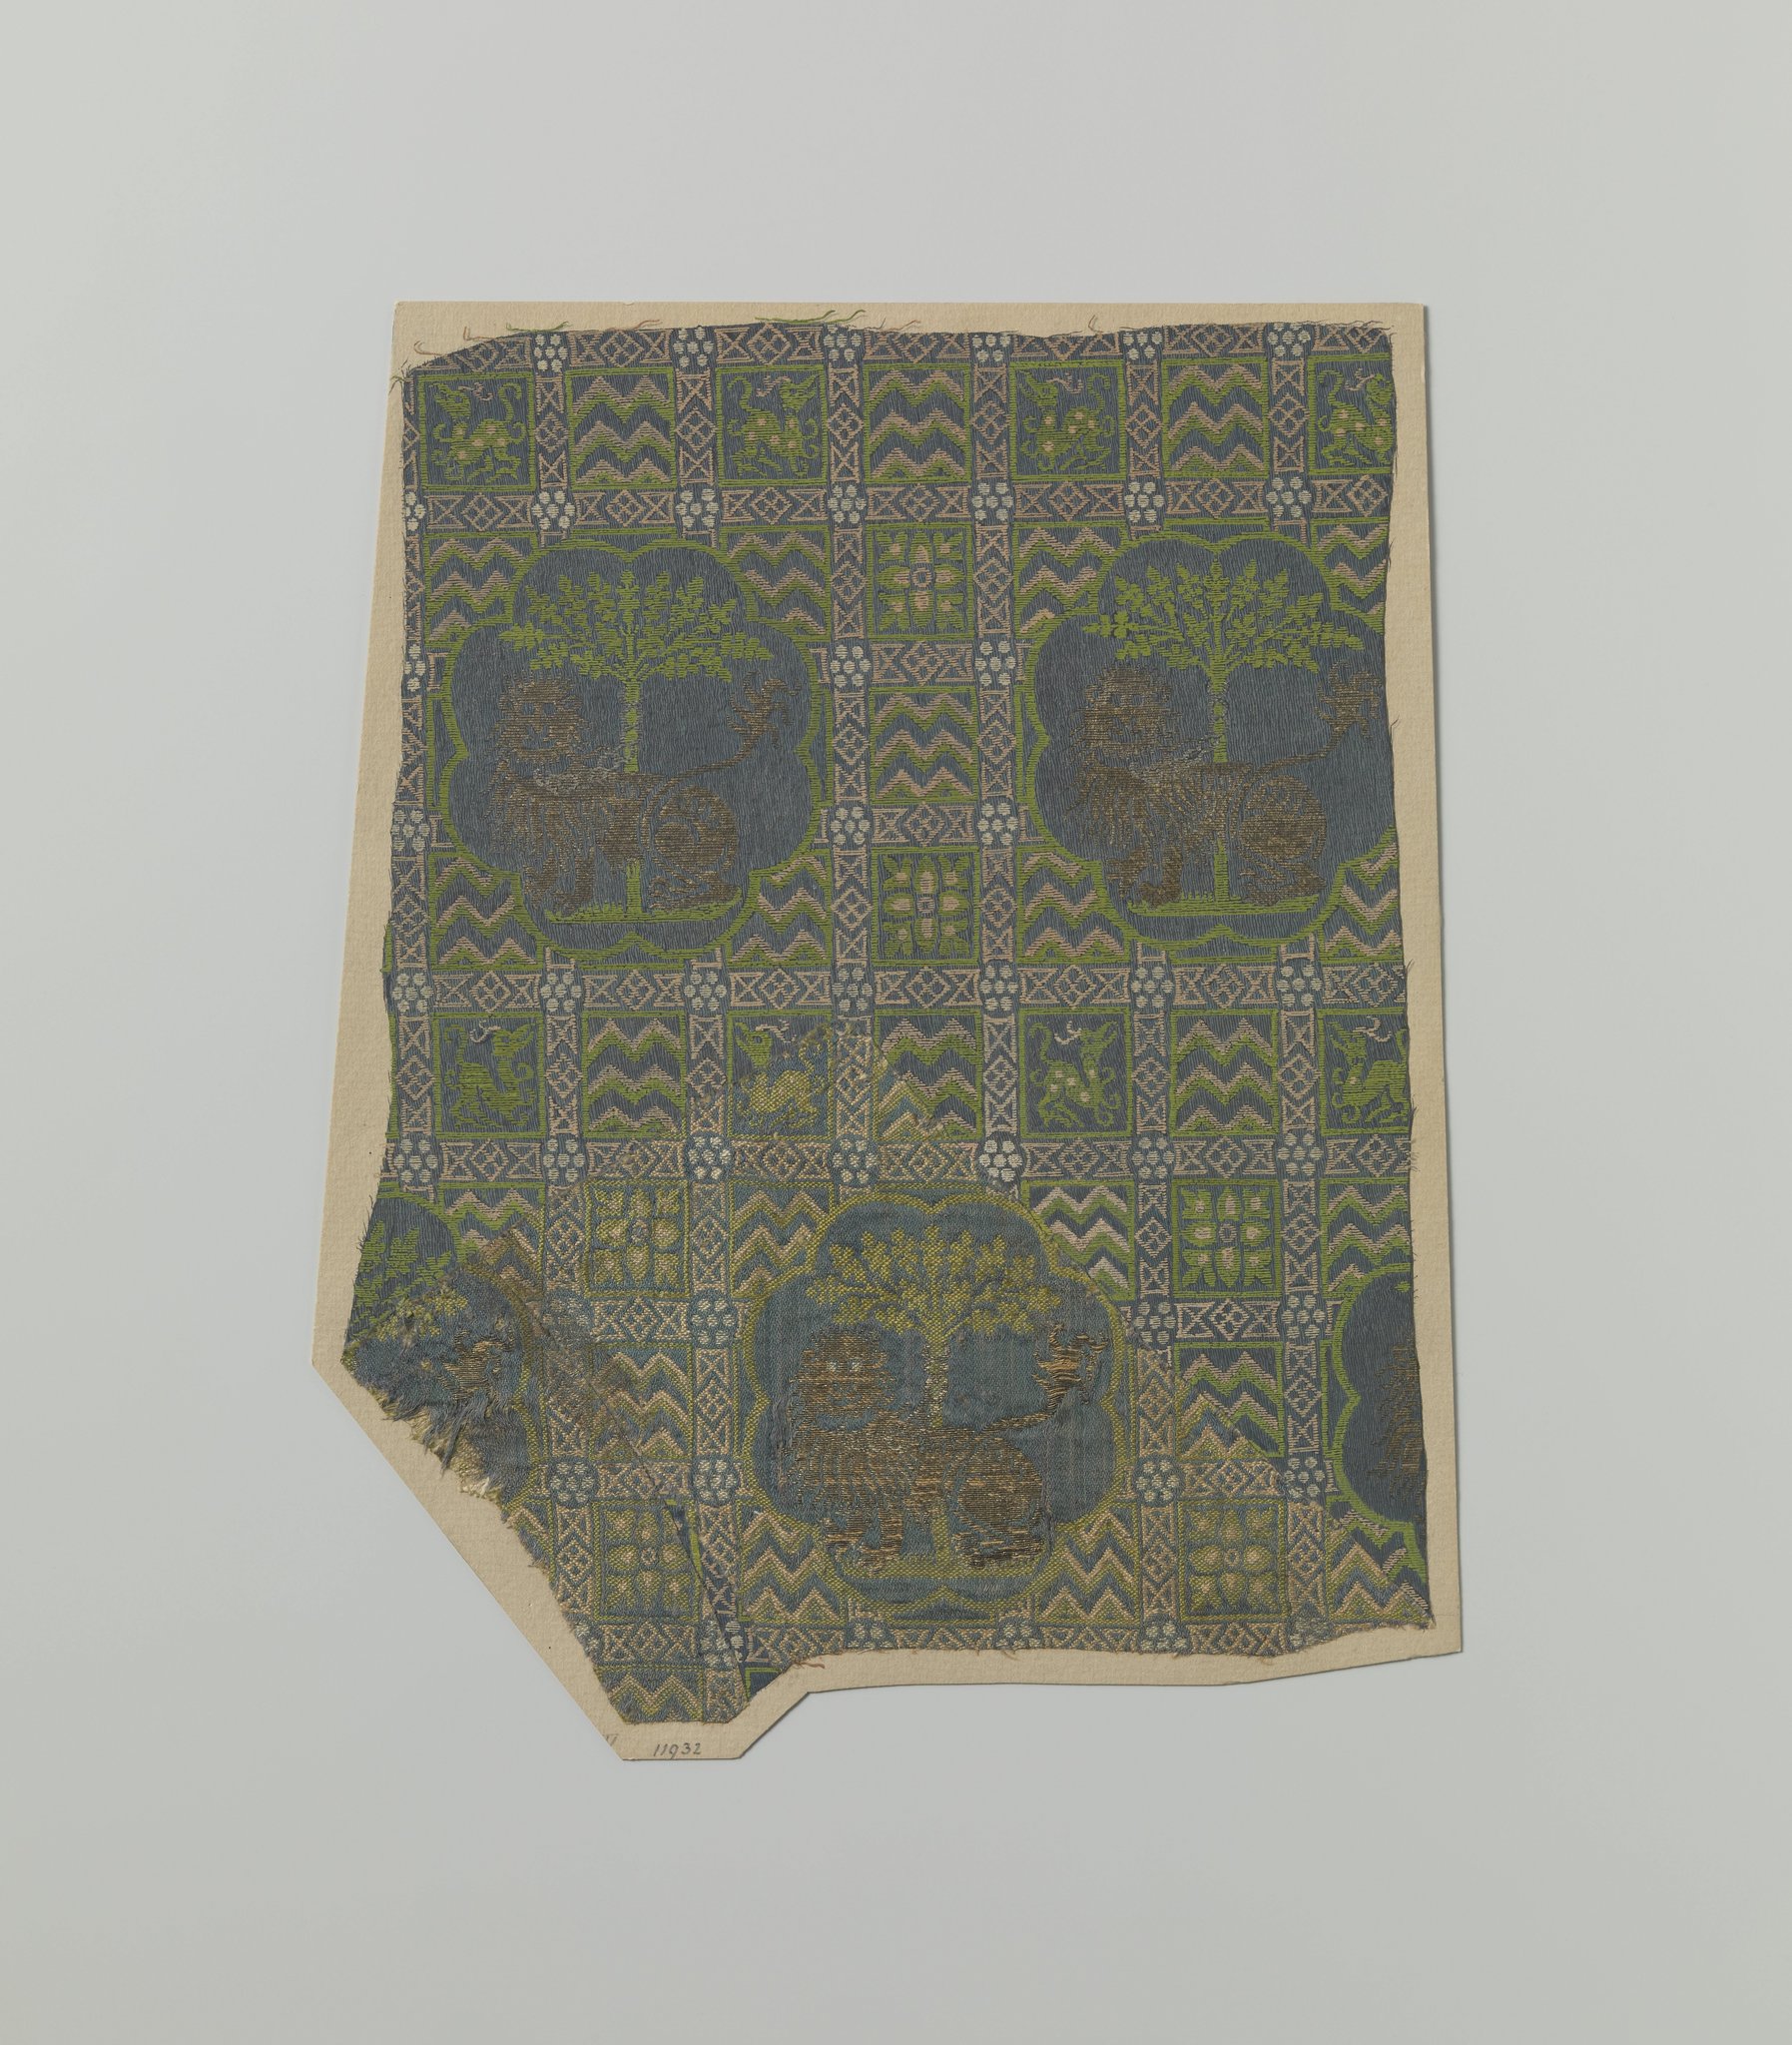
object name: silk textile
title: Fragment zijdeweefsel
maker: paul schulze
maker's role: museumdirecteur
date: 1200-1299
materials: silk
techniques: lampas, weave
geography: spain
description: Fragment (bestaande uit twee stukken) van blauwe zijde met patroon in o.a. wit, groen en goud, met achtpassen met daarin voorstelling van geketende leeuw aan boom. Bijgetekend. Onvolledig rapport.